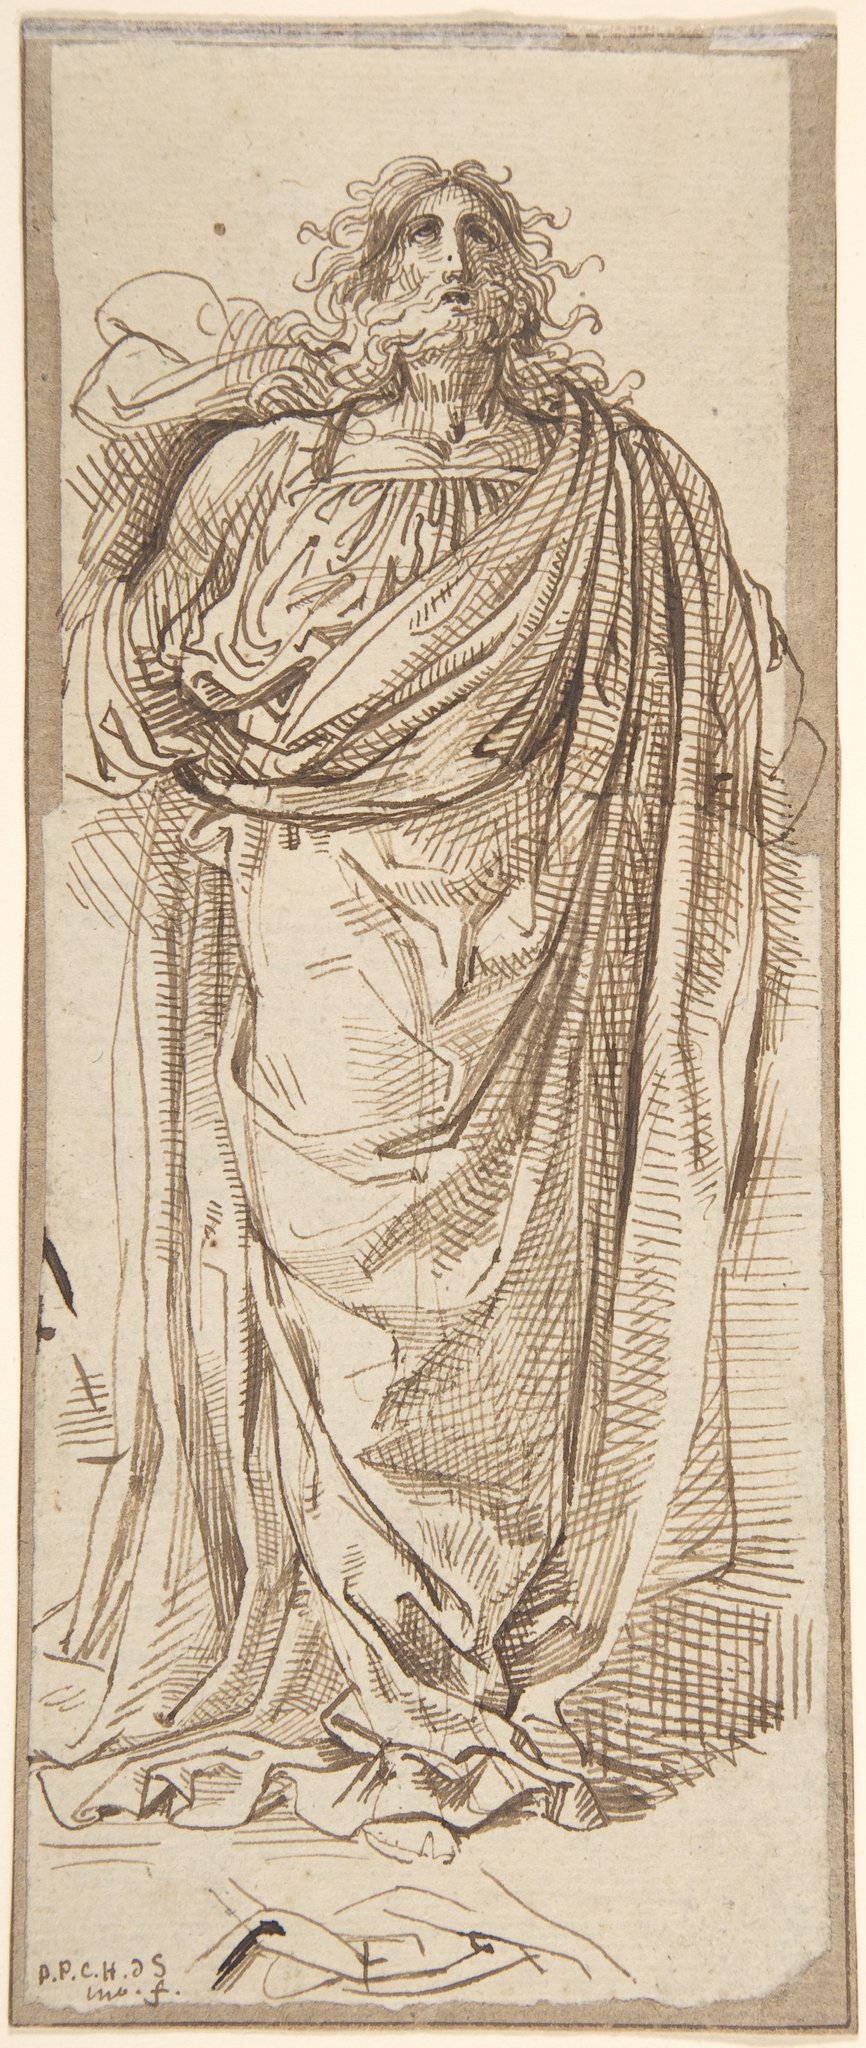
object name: drawing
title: A Draped Bearded Man Looking Up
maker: david-pierre giottino humbert de superville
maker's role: artist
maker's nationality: dutch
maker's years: 1770-1849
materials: ink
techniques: pen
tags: men